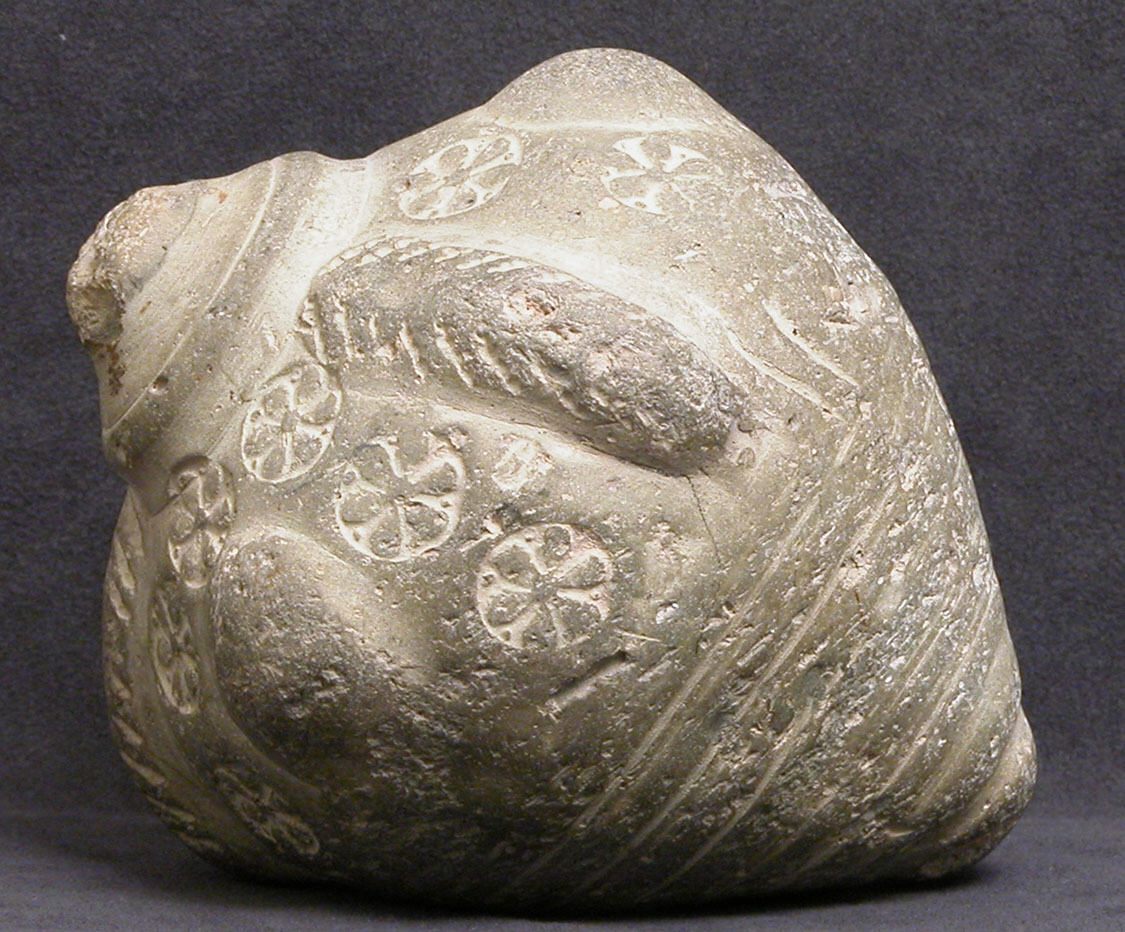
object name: vessel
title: Spheroconical Vessel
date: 1001-1200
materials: earthenware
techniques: incising, stamping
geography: iraq